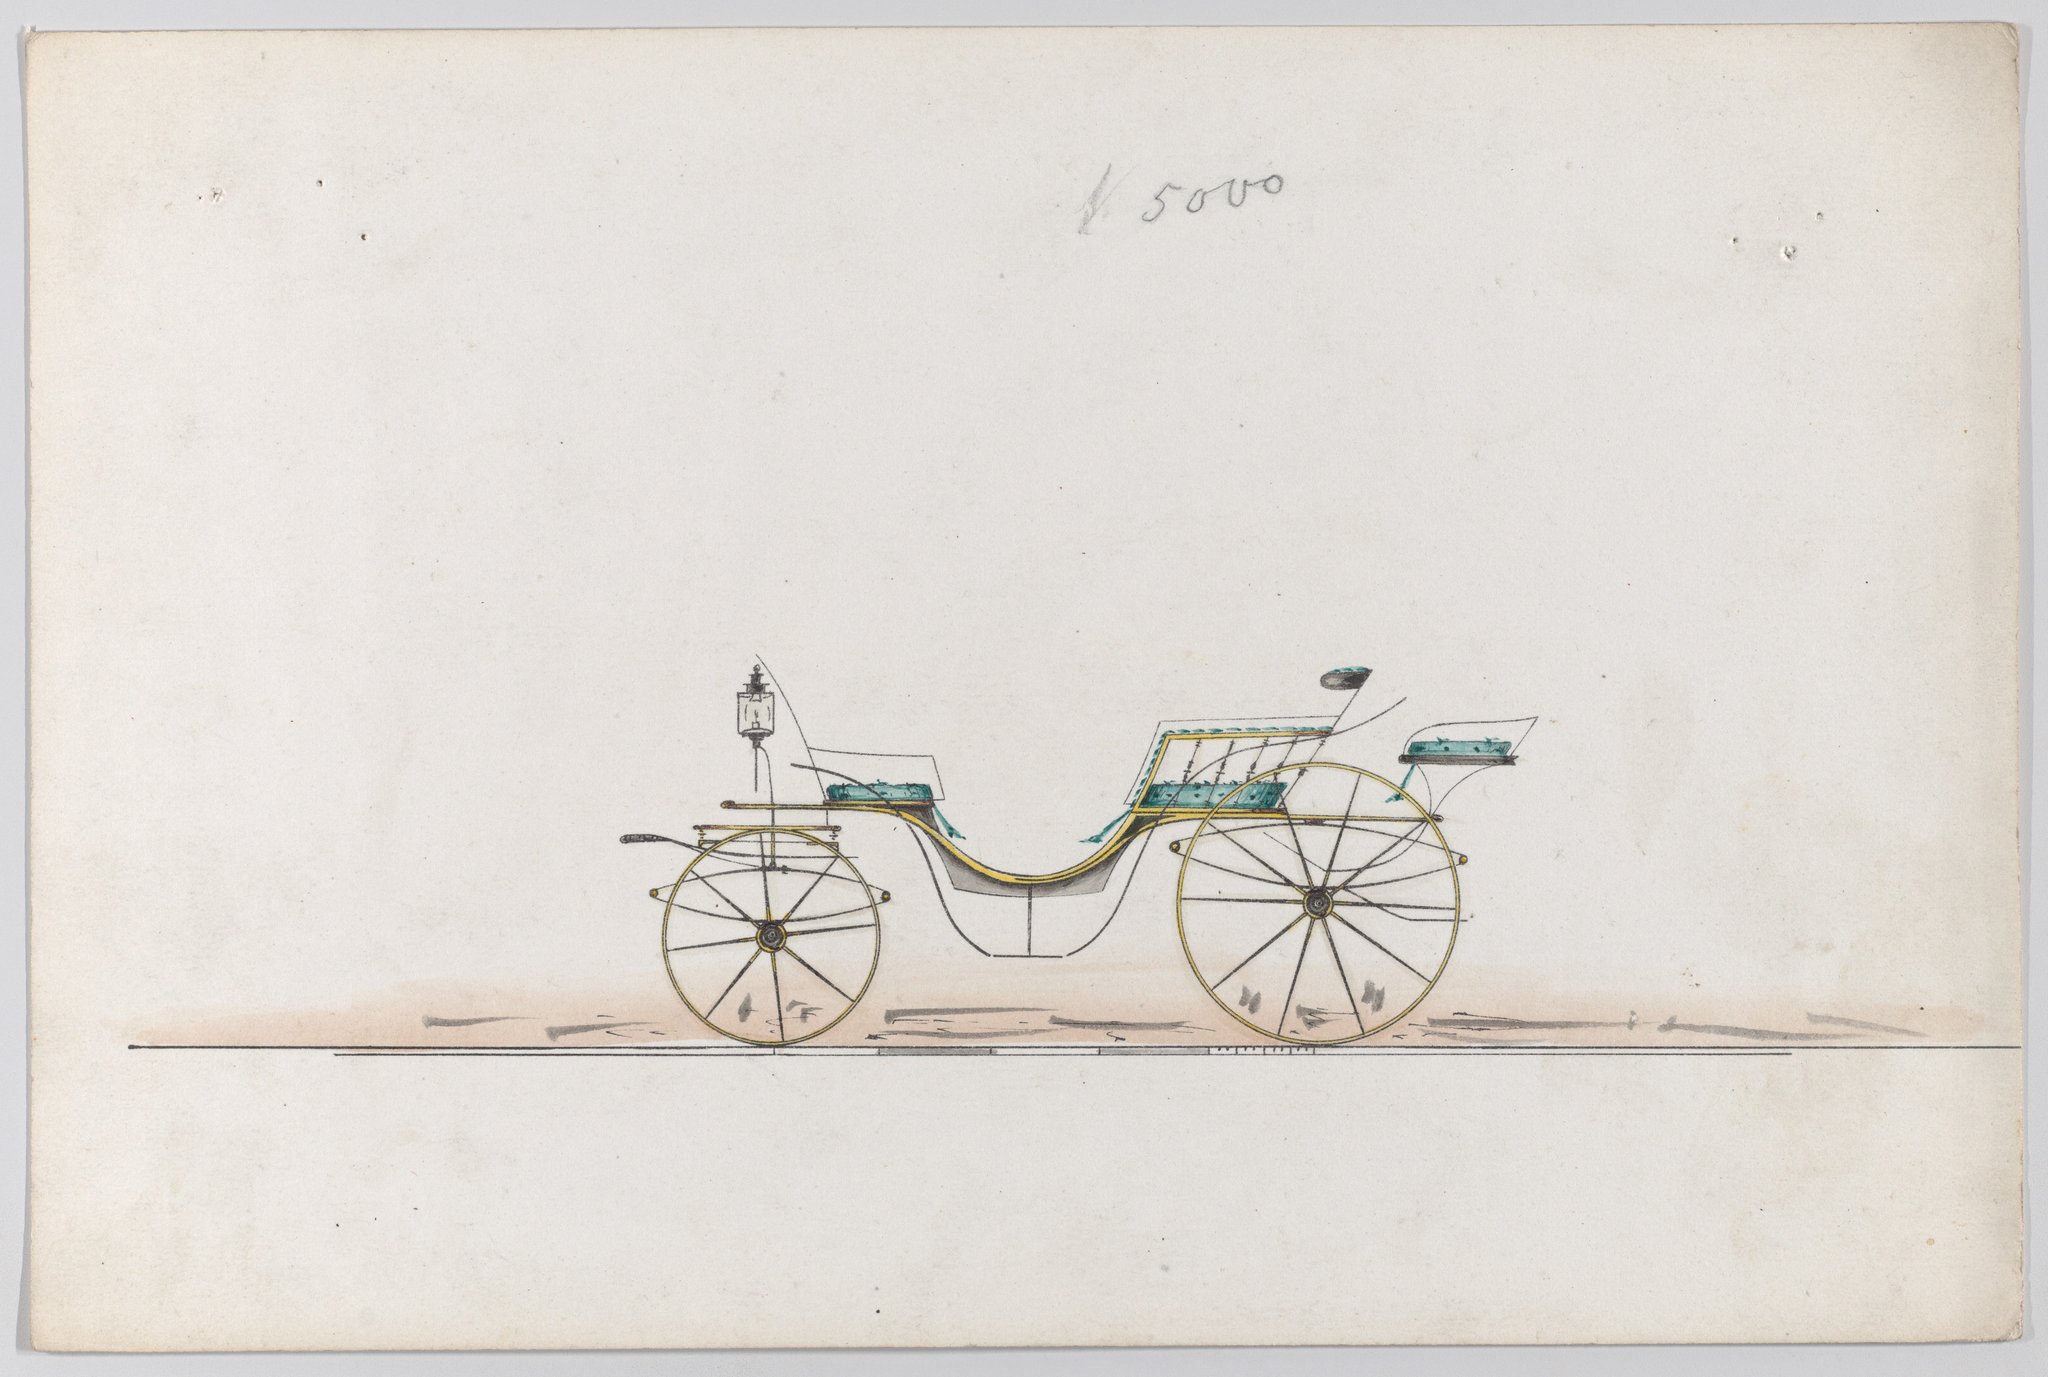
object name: drawing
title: Design for Vis-à-vis Phaeton (unnumbered)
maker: brewster & co.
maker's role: manufacturer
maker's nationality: american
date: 1870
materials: gouache, ink, watercolor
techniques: pen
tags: carriages